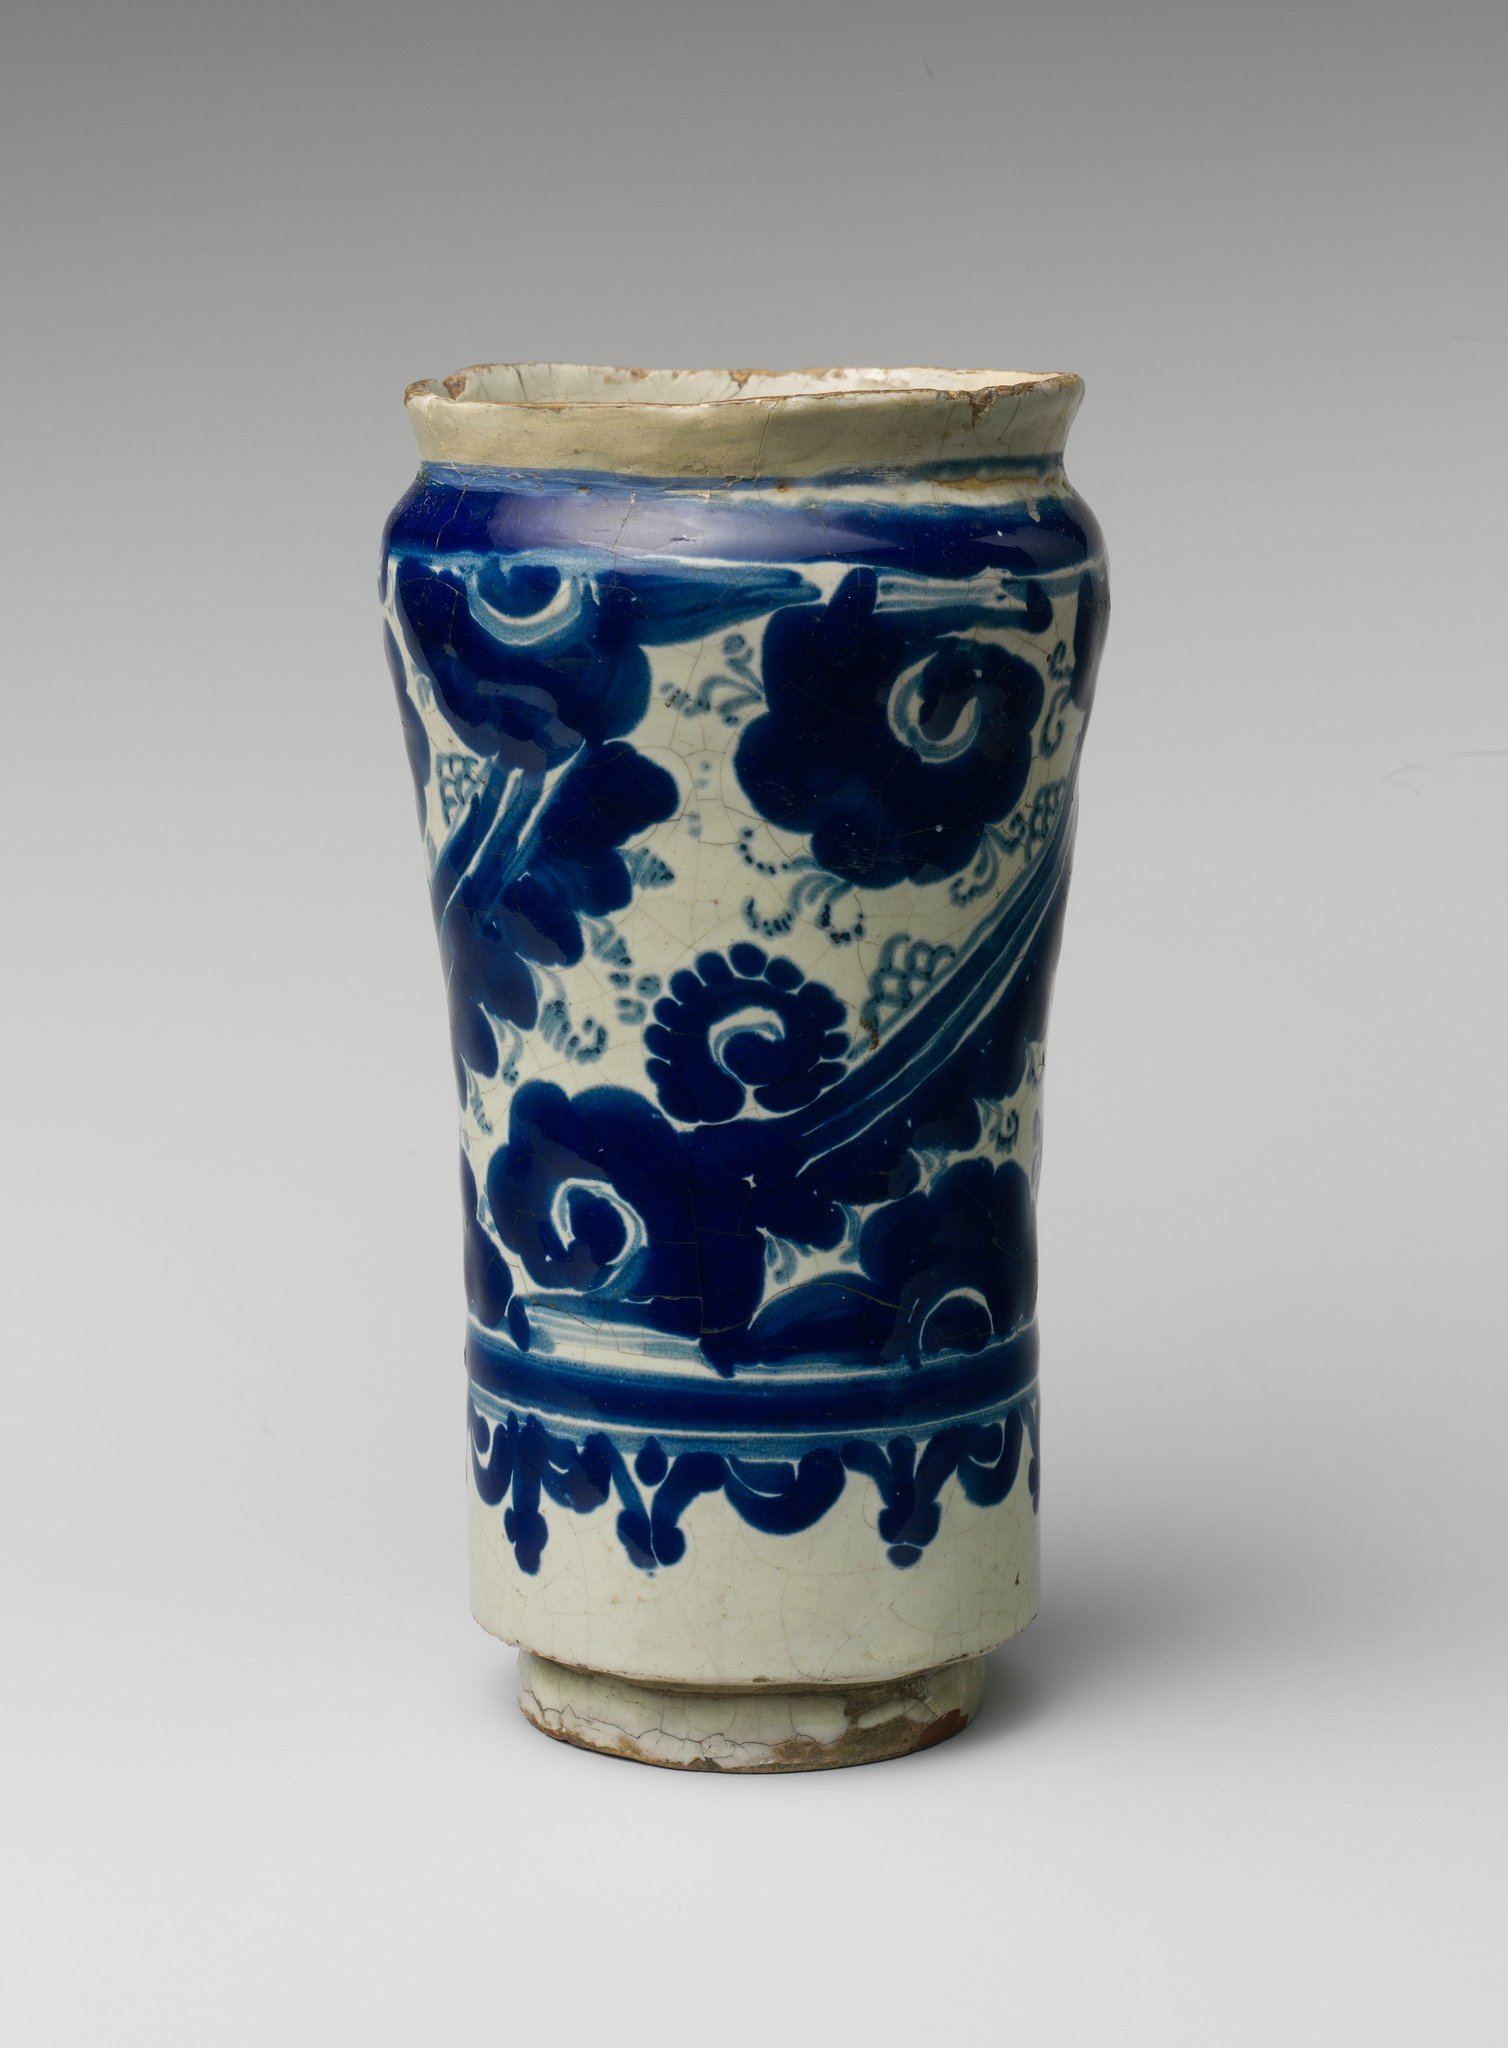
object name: apothecary jar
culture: mexican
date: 1700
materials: earthenware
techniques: glazing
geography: mexico